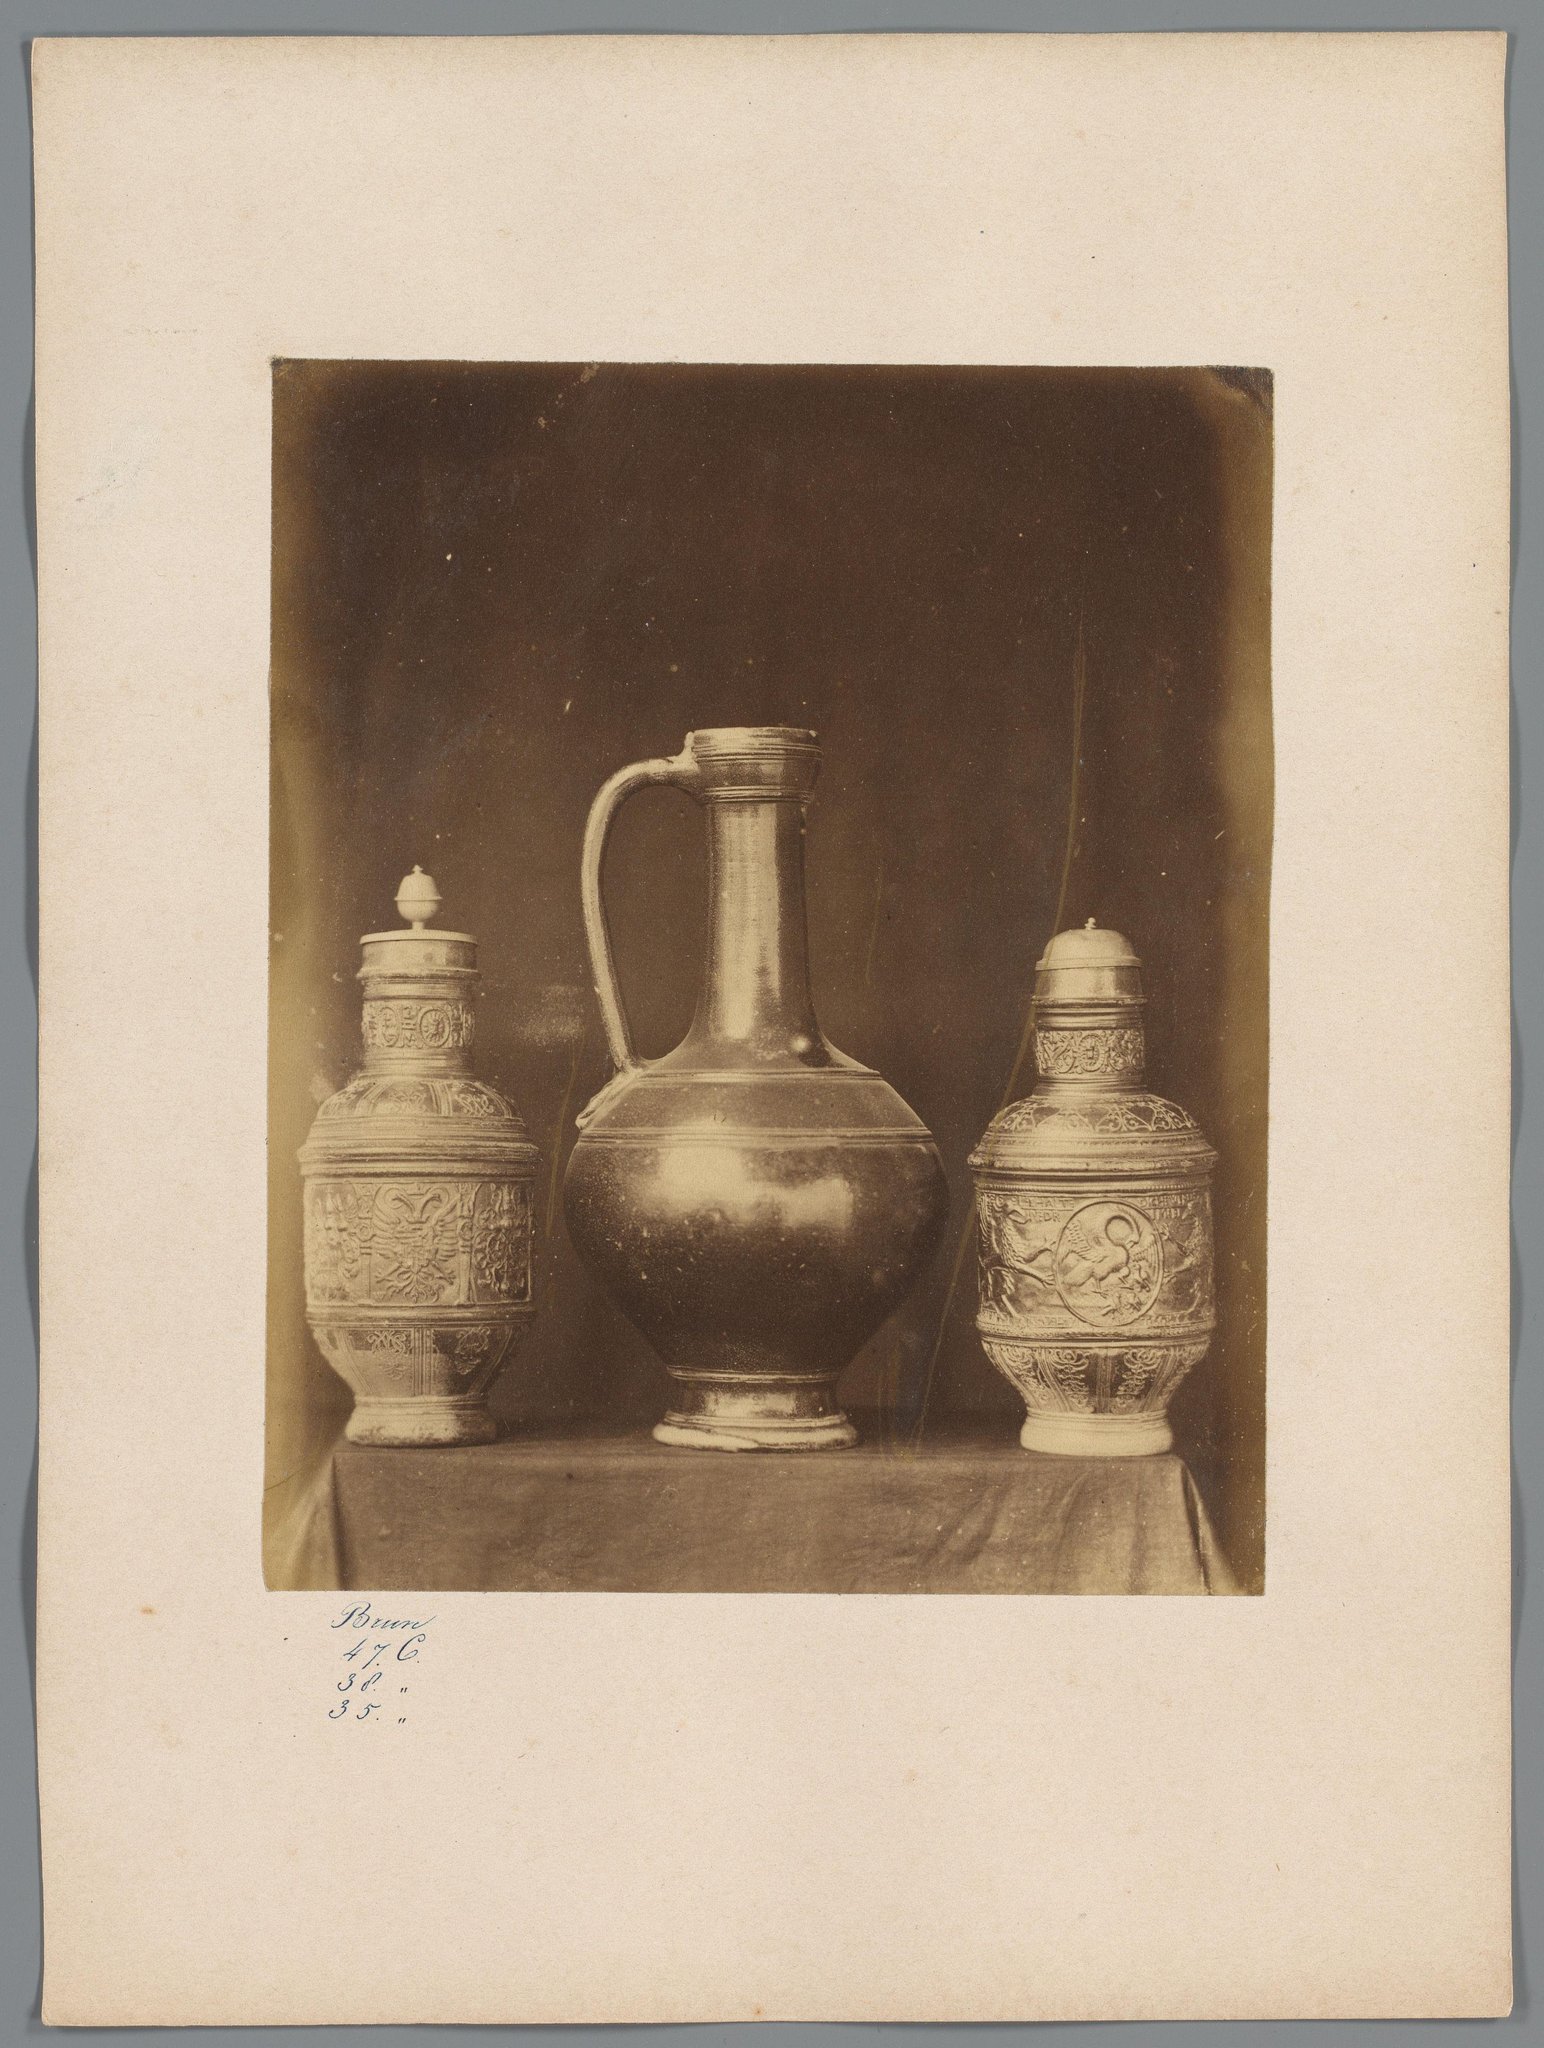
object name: photograph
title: Drie aardewerken vazen uit de collectie van W. de Weckherlin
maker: Anonymous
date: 1860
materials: paper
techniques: albumen print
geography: the hague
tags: container of ceramics: jar, jug, pot, vase, the hague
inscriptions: inscription: ‘Brun/ 47G/ 38"/ 35"’